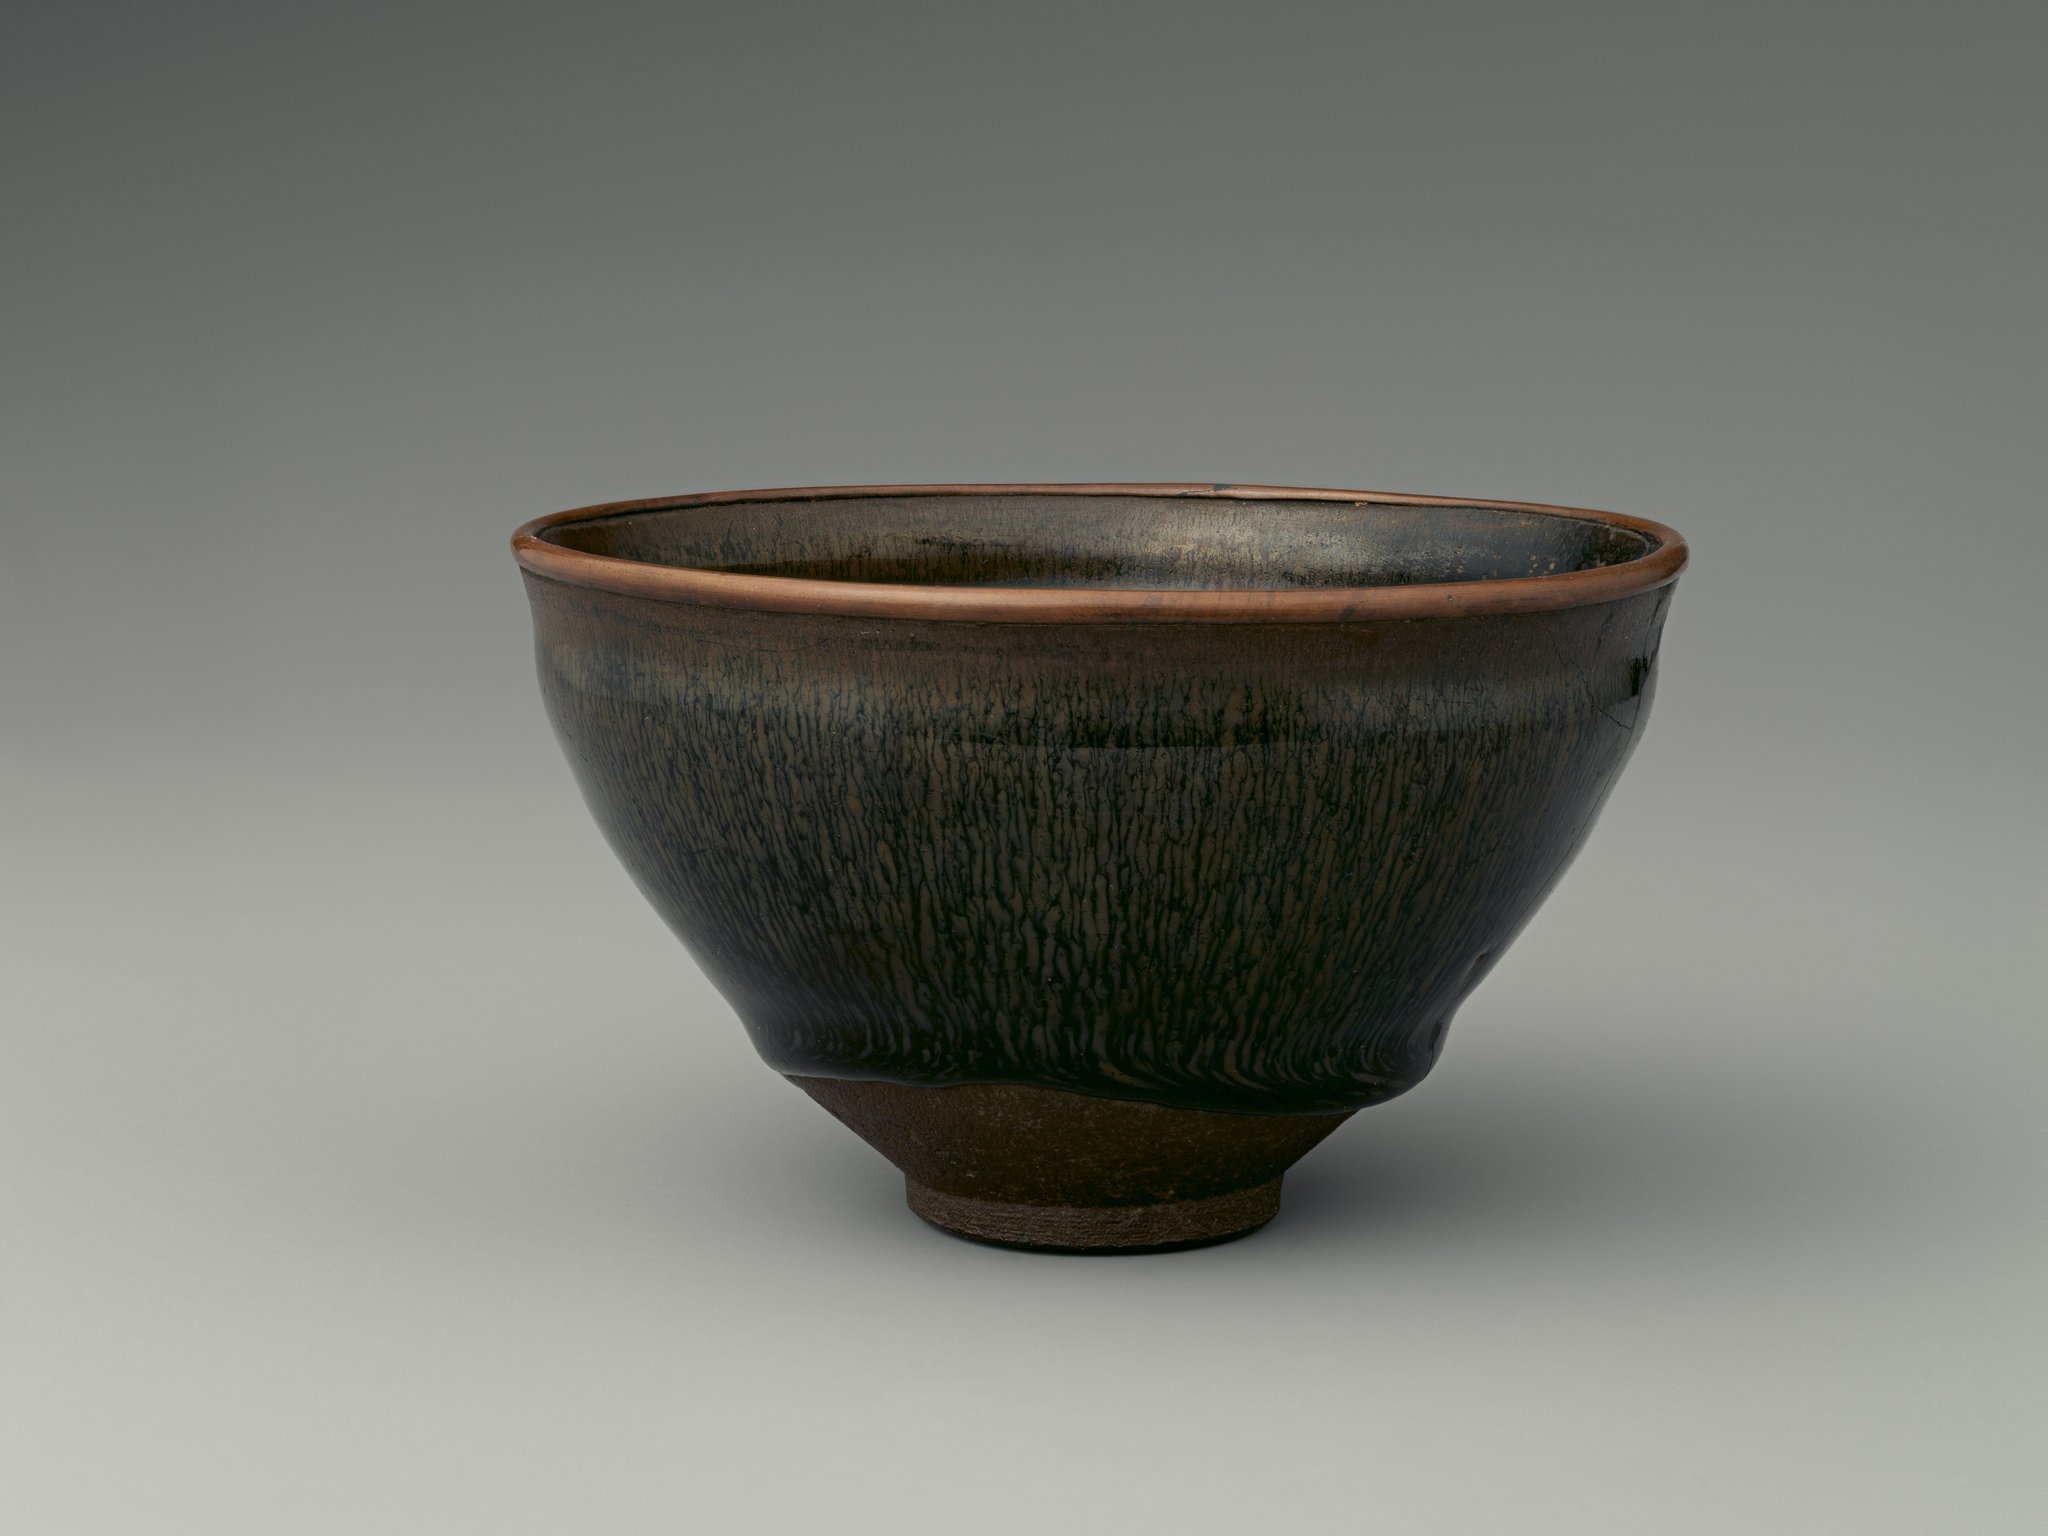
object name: teabowl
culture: chinese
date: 1101-1300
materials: copper, stoneware